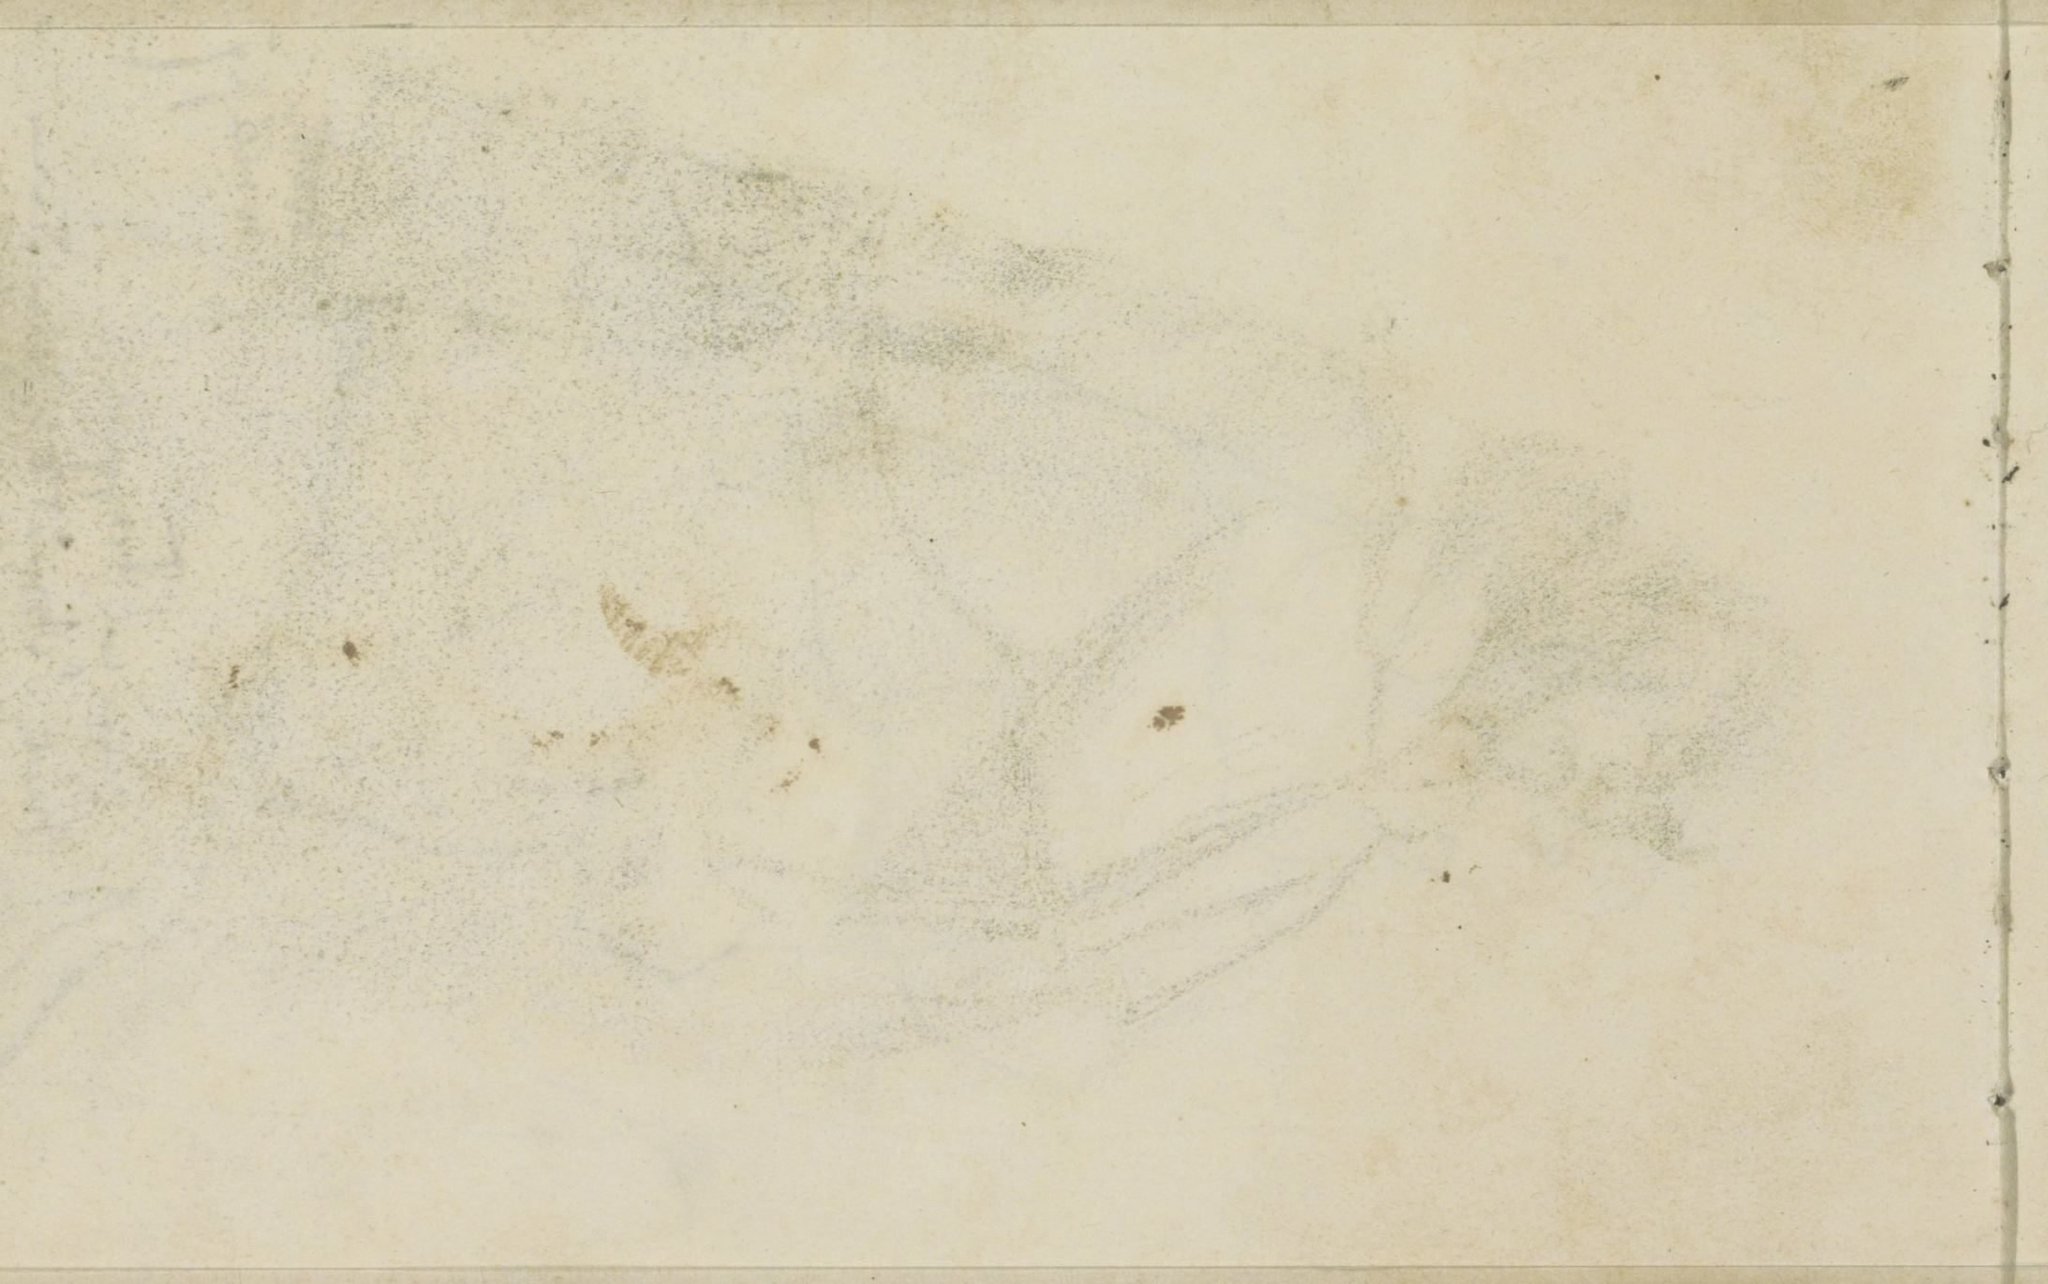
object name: sketchbook leaf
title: Abklatsch van de potloodtekening op pagina 12 recto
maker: johannes tavenraat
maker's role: draughtsman, painter, print maker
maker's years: 1809-1881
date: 1839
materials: paper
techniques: printmaking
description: Blad 11 verso uit een schetsboek met 37 bladen.